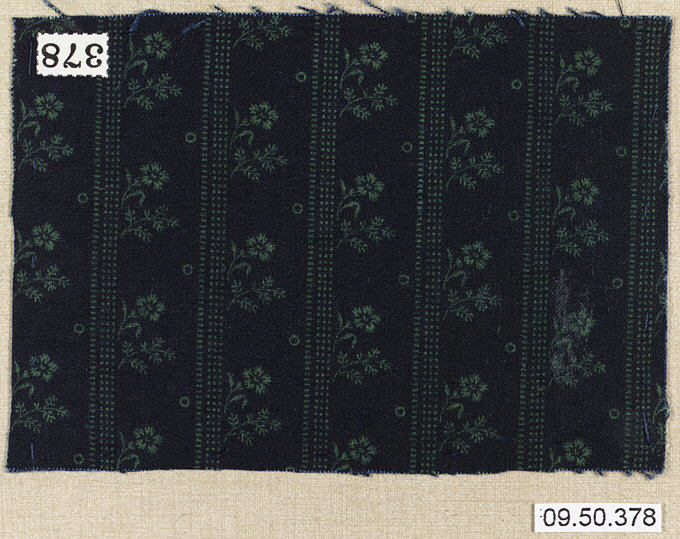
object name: piece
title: Piece (one of 116)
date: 1801-1900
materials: cotton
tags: flowers,leaves